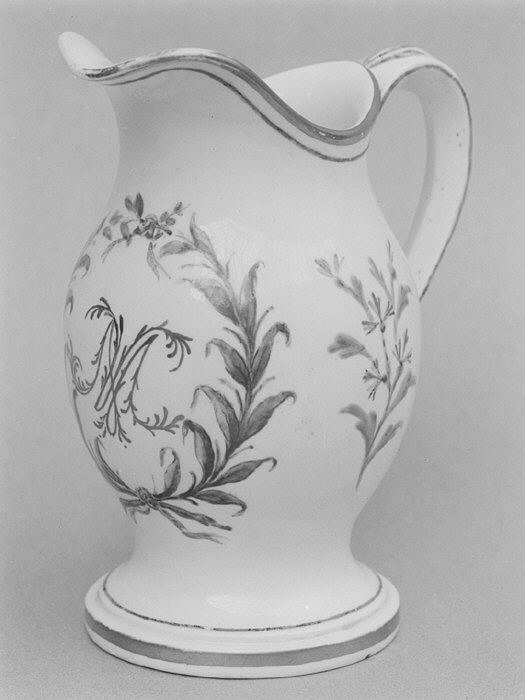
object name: jug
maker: real fabrica de buen retiro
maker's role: factory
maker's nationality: spanish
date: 1767-1800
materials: soft paste porcelain